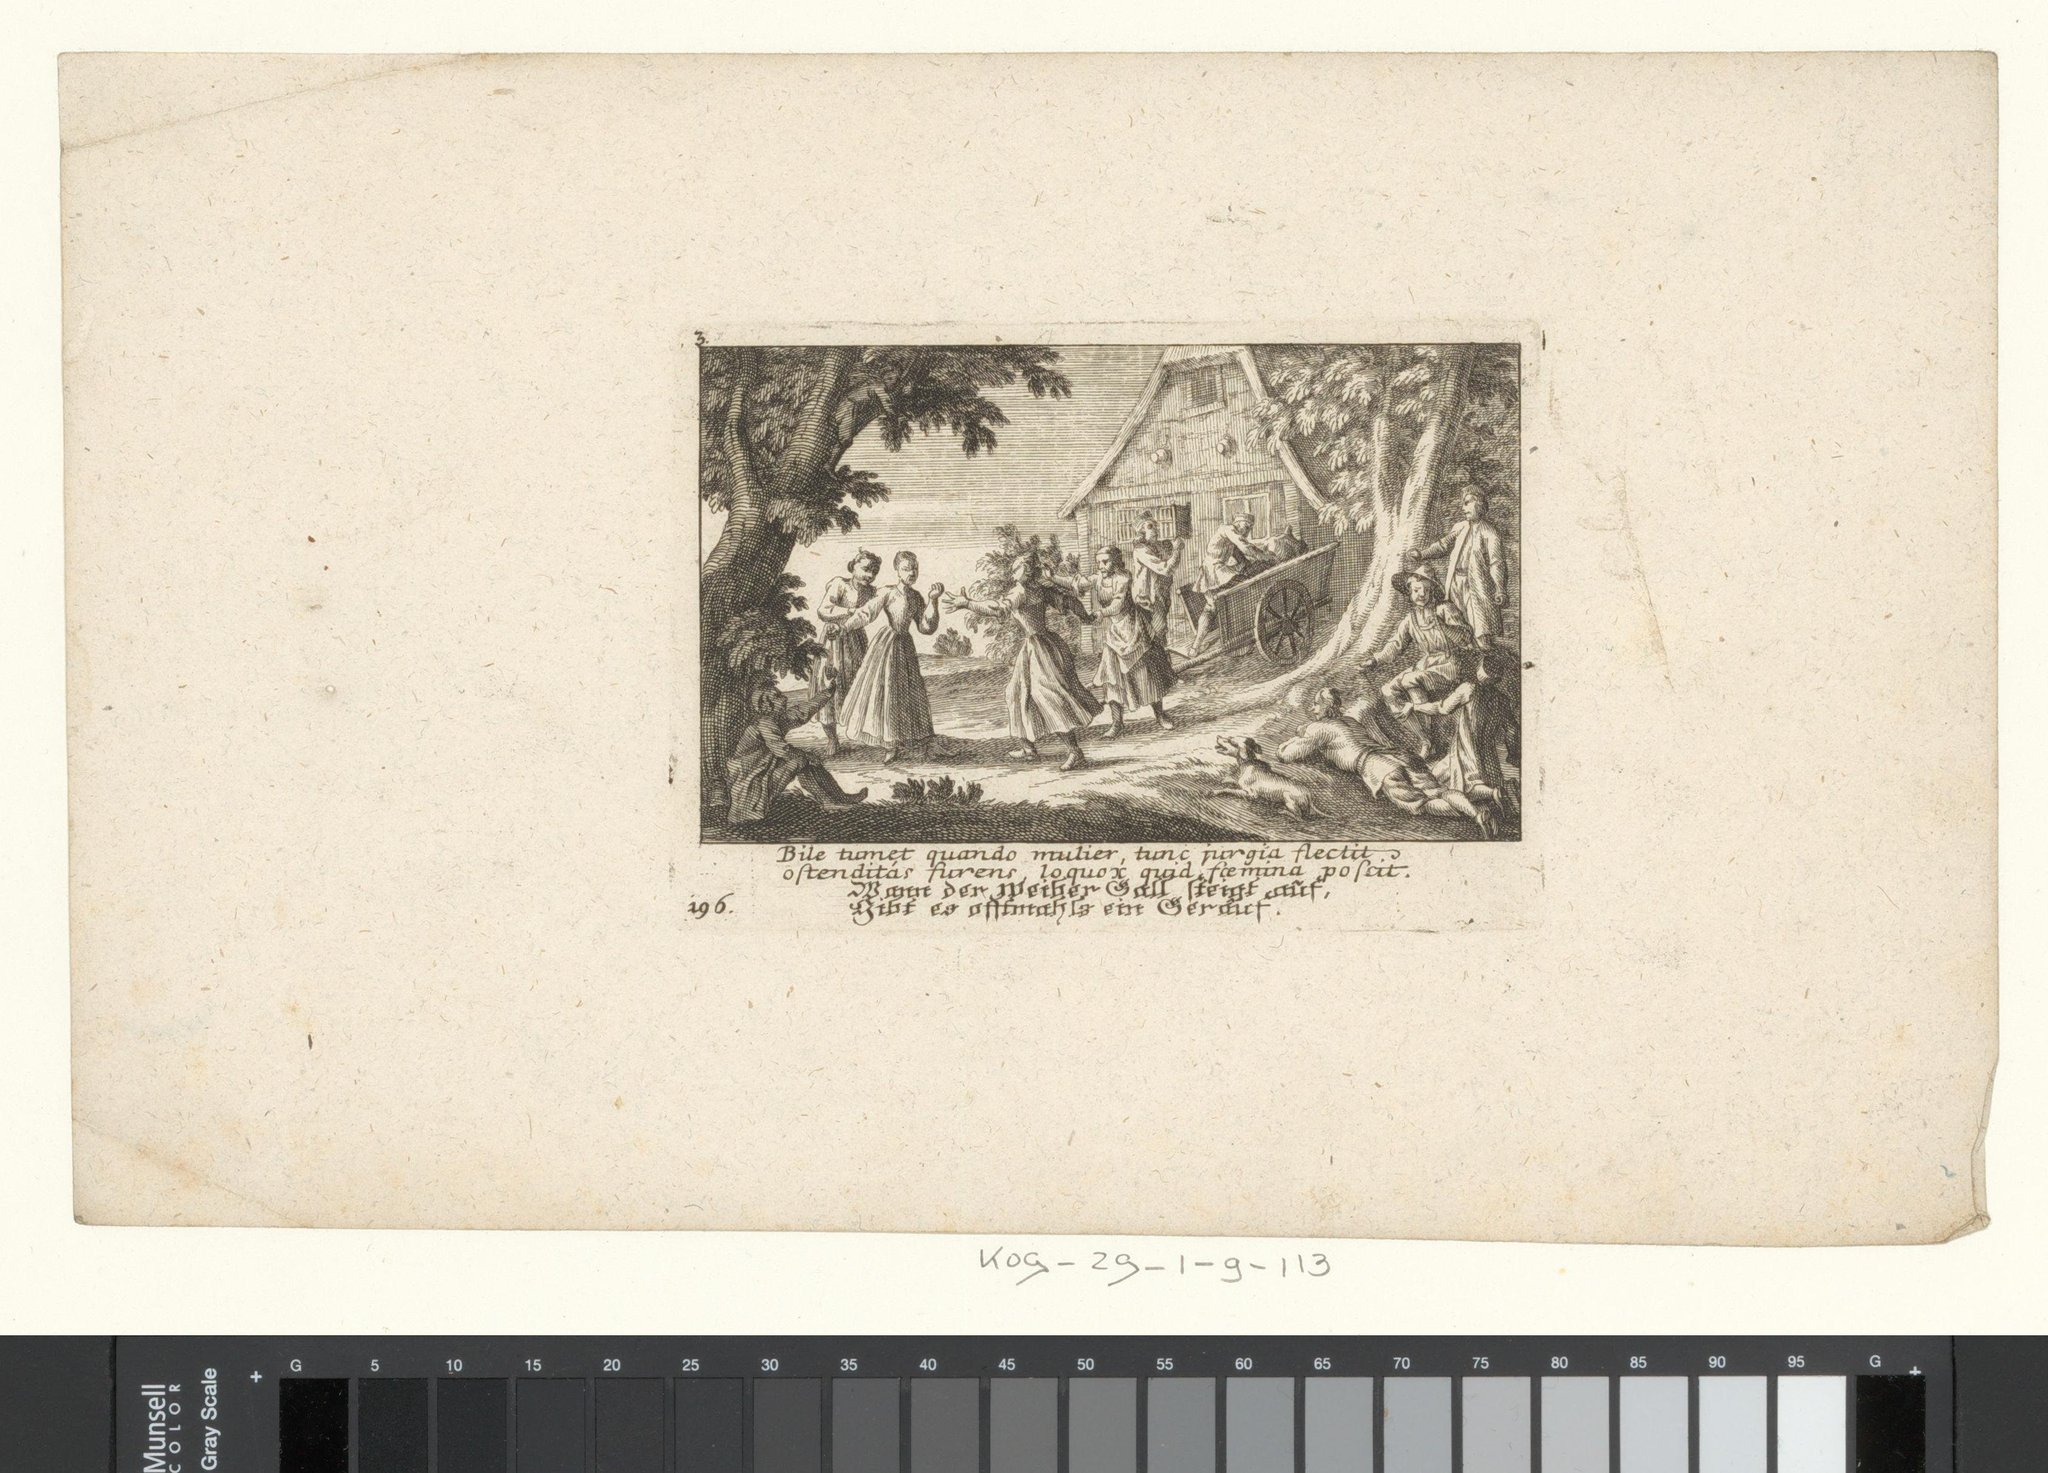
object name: print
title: Dansende vrouwen voor een herberg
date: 1694-1744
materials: paper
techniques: engraving, etching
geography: augsburg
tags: dancing, hotel, hostelry, inn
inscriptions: stamp, collector's mark: Lugt 1641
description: Onderaan vier regels tekst in het Frans en Duits. Linksboven genummerd: 3. Linksonder gesigneerd: 196. Onderwerpsrubrieken binnen de Atlas Zeden en Gewoonten: Handel, nijverheid en verkeer, Boerenleven.